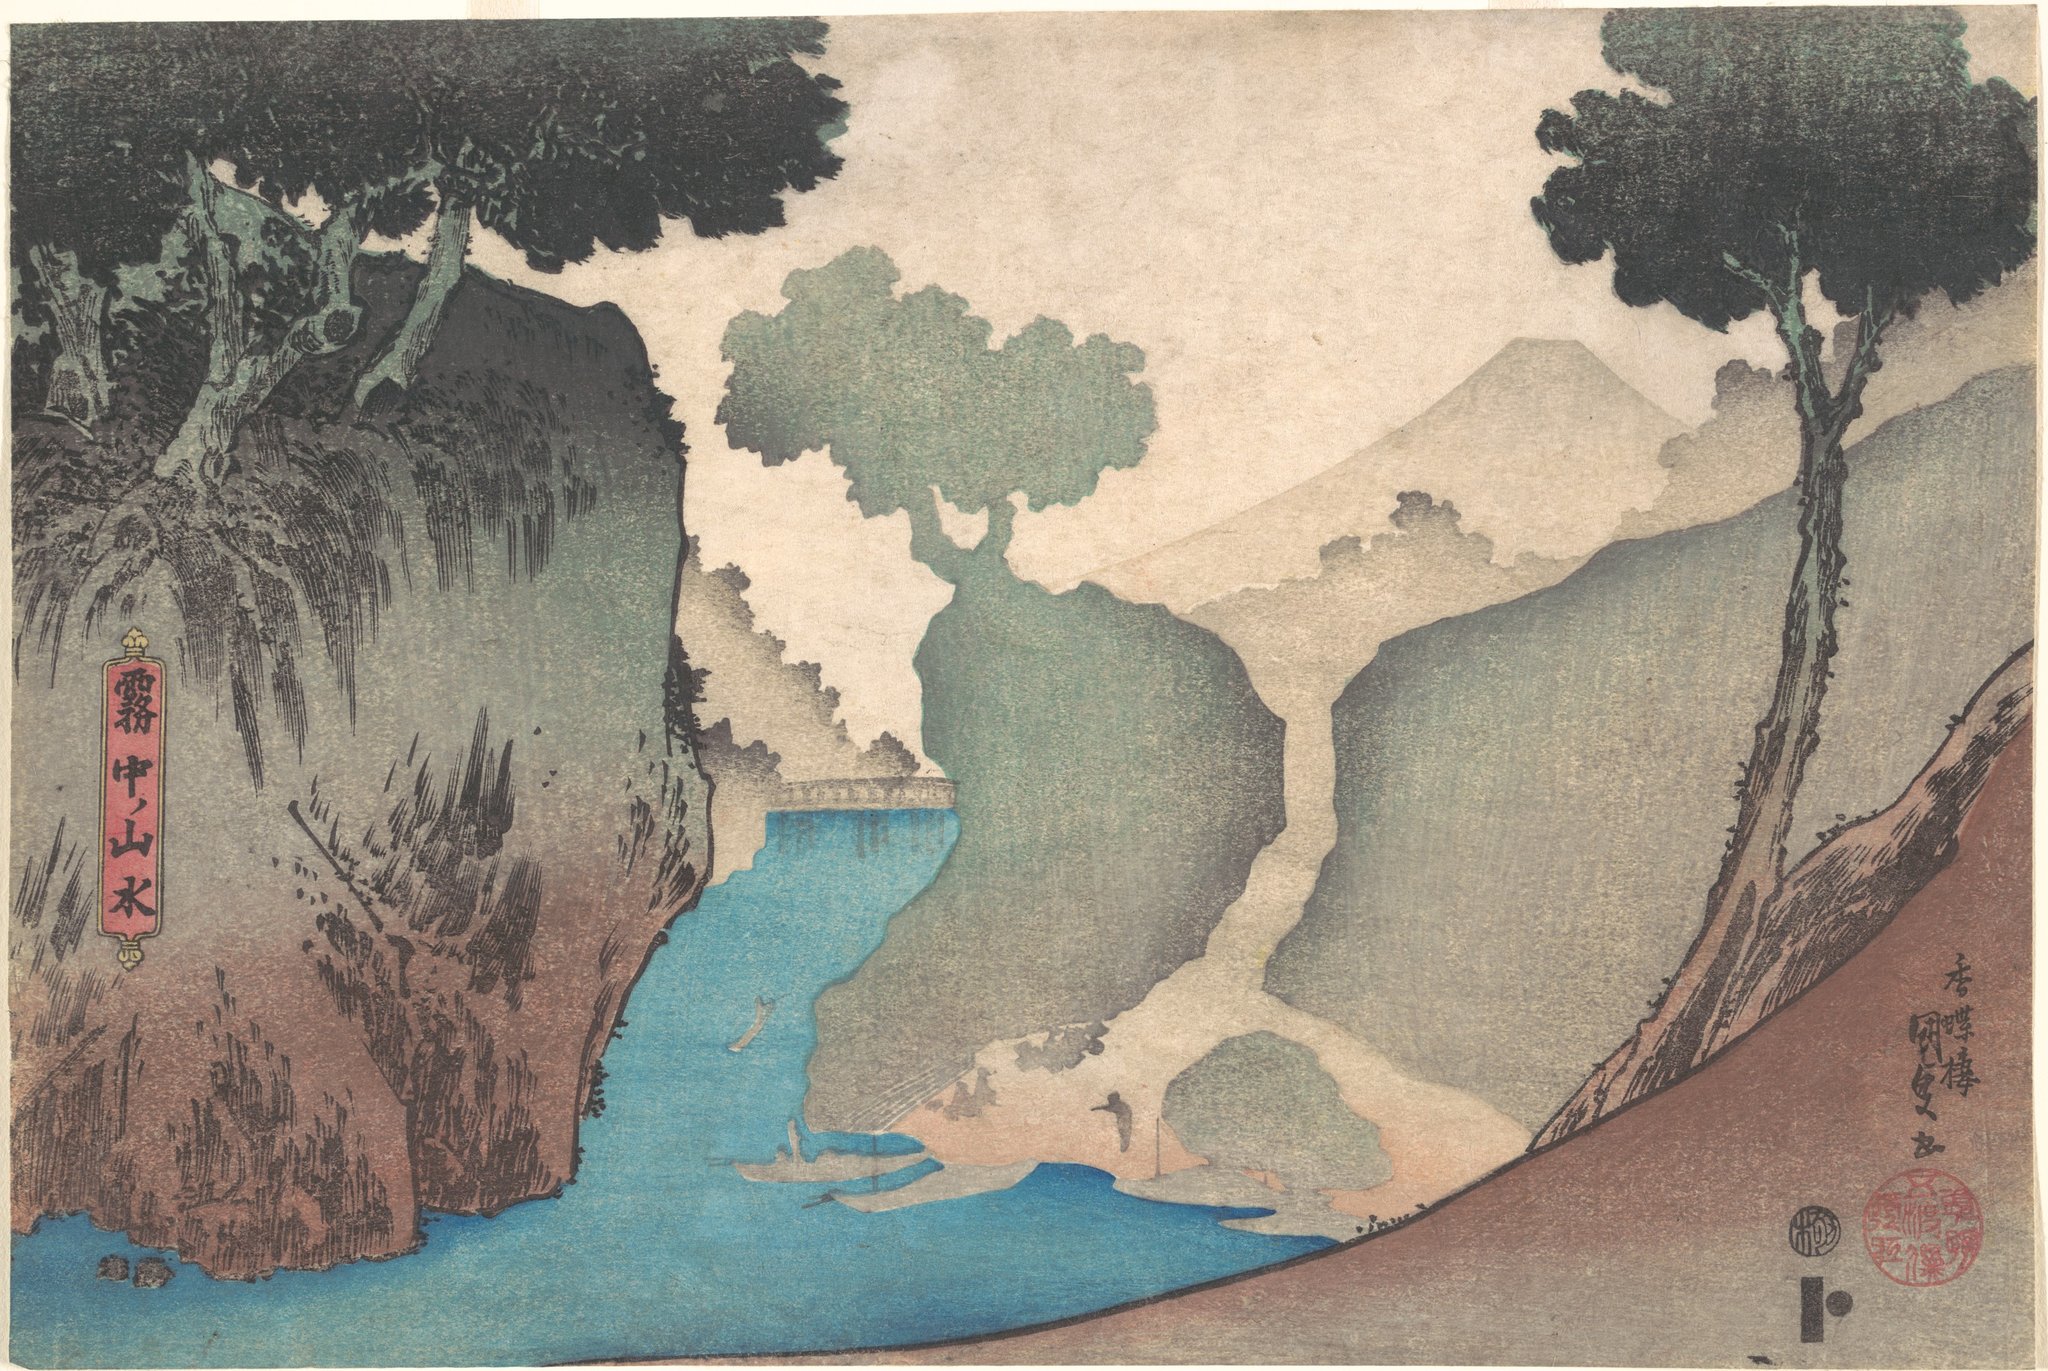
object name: print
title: Landscape in the Mist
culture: japanese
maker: utagawa kunisada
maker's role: artist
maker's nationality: japanese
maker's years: 1786-1864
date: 1834-1866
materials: ink, paper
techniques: woodblock print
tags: mountains,landscapes,streams